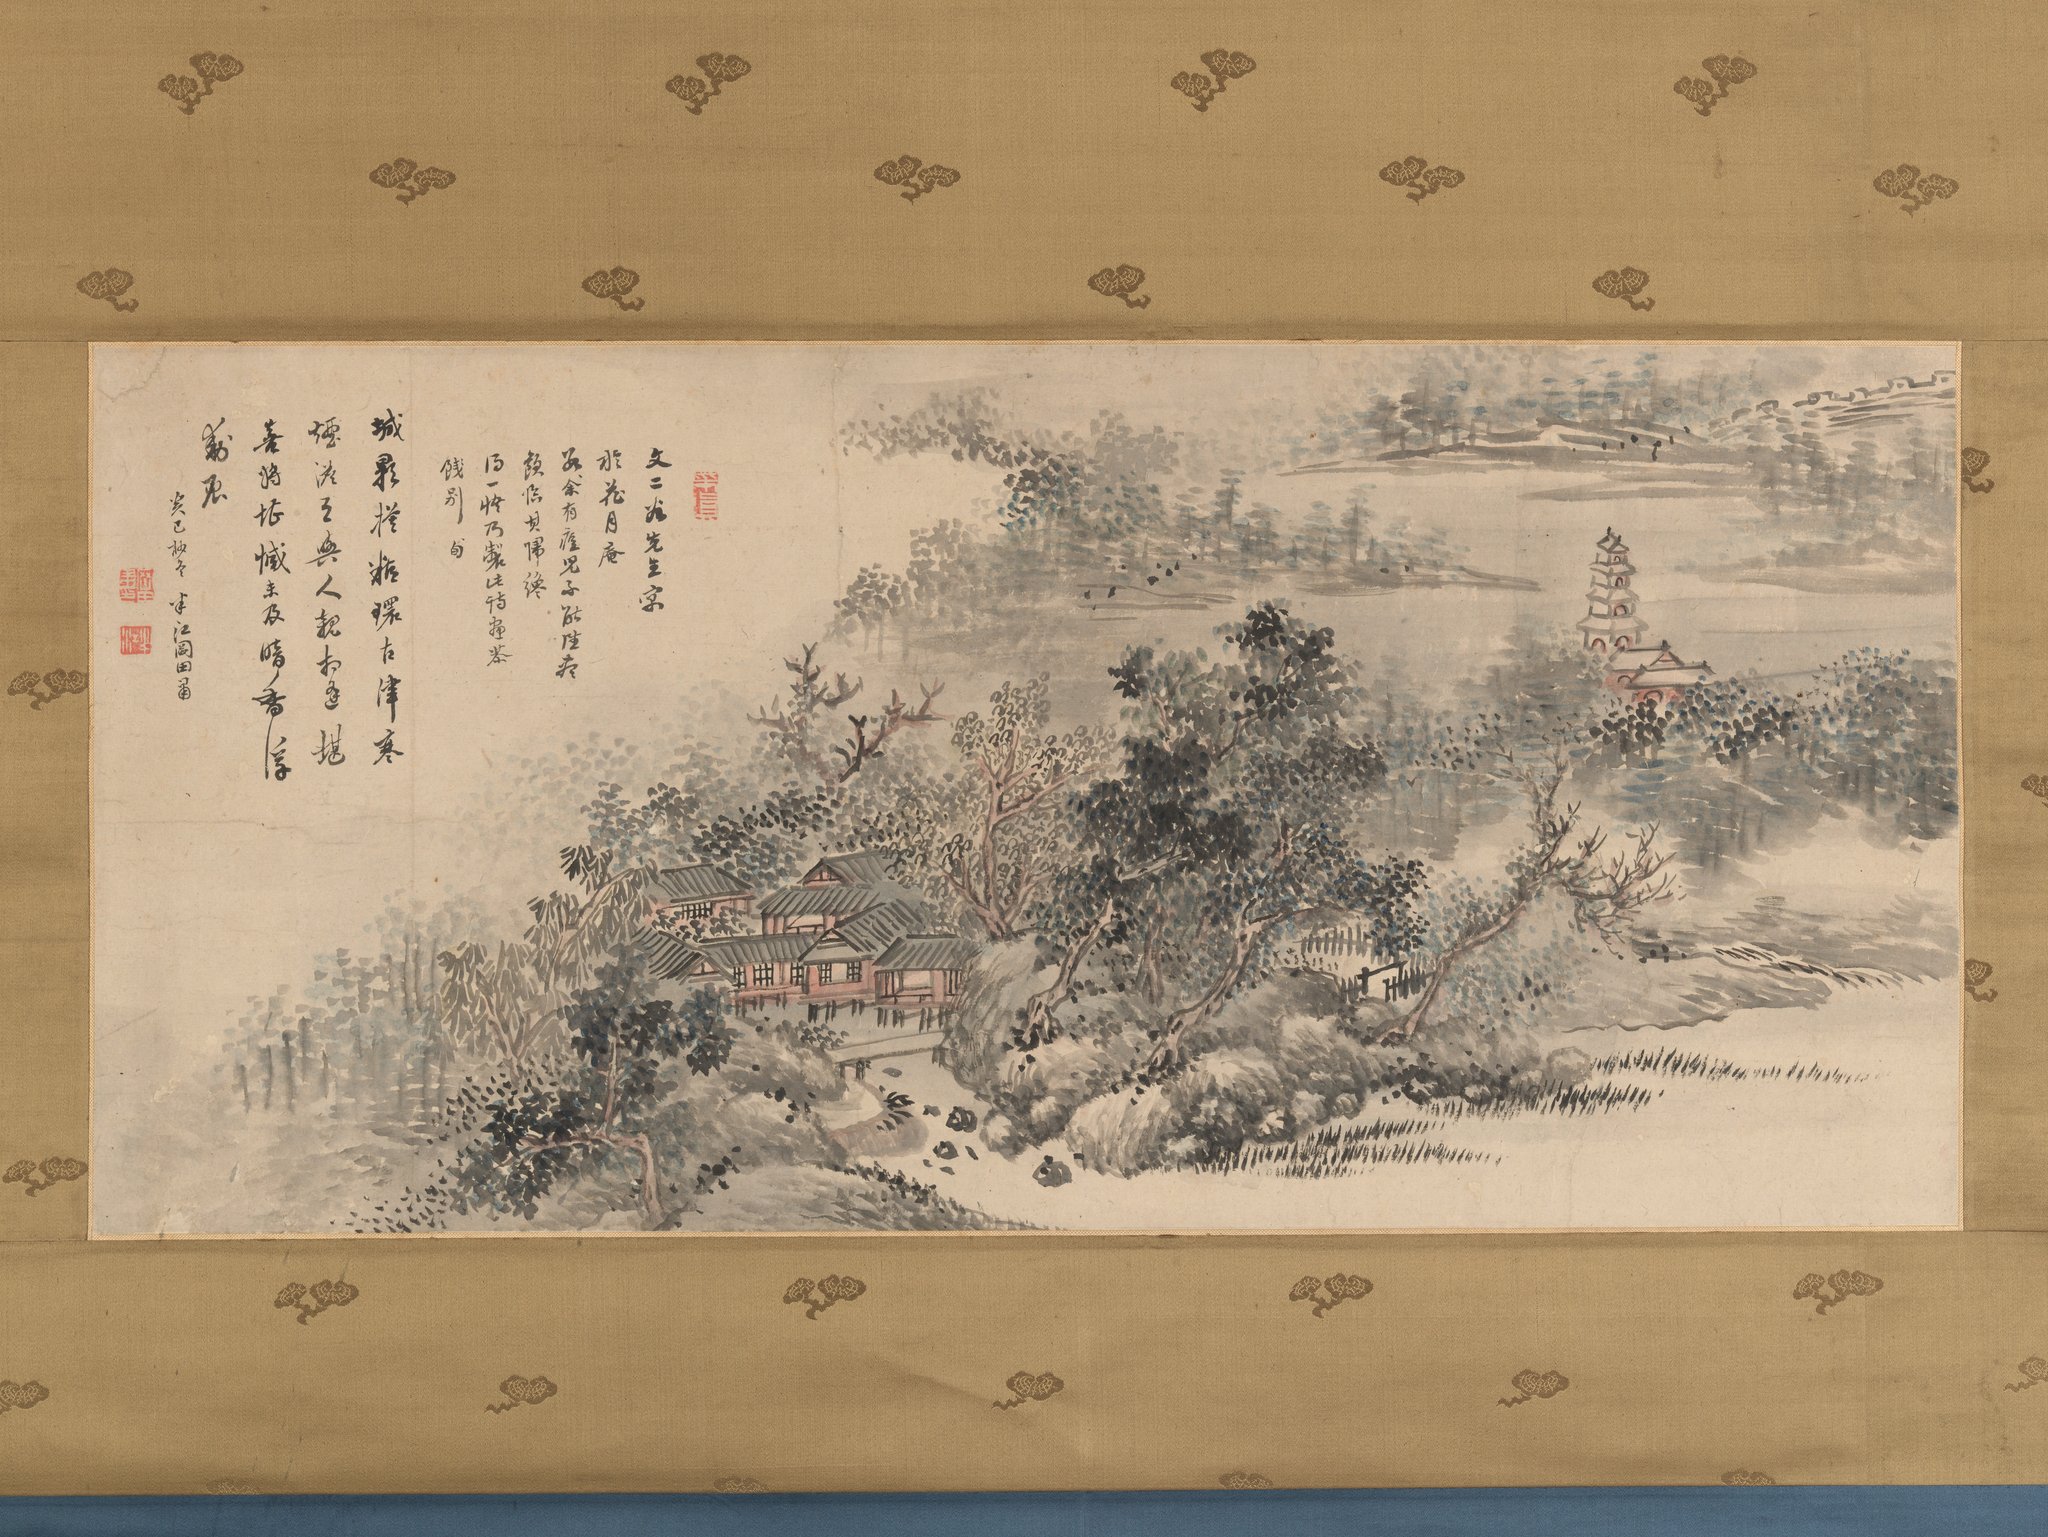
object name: hanging scroll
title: Farewell Gift to Tani Bunji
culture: japanese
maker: okada hankō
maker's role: artist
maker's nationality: japanese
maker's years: 1782-1846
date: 1833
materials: ink, paper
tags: landscapes